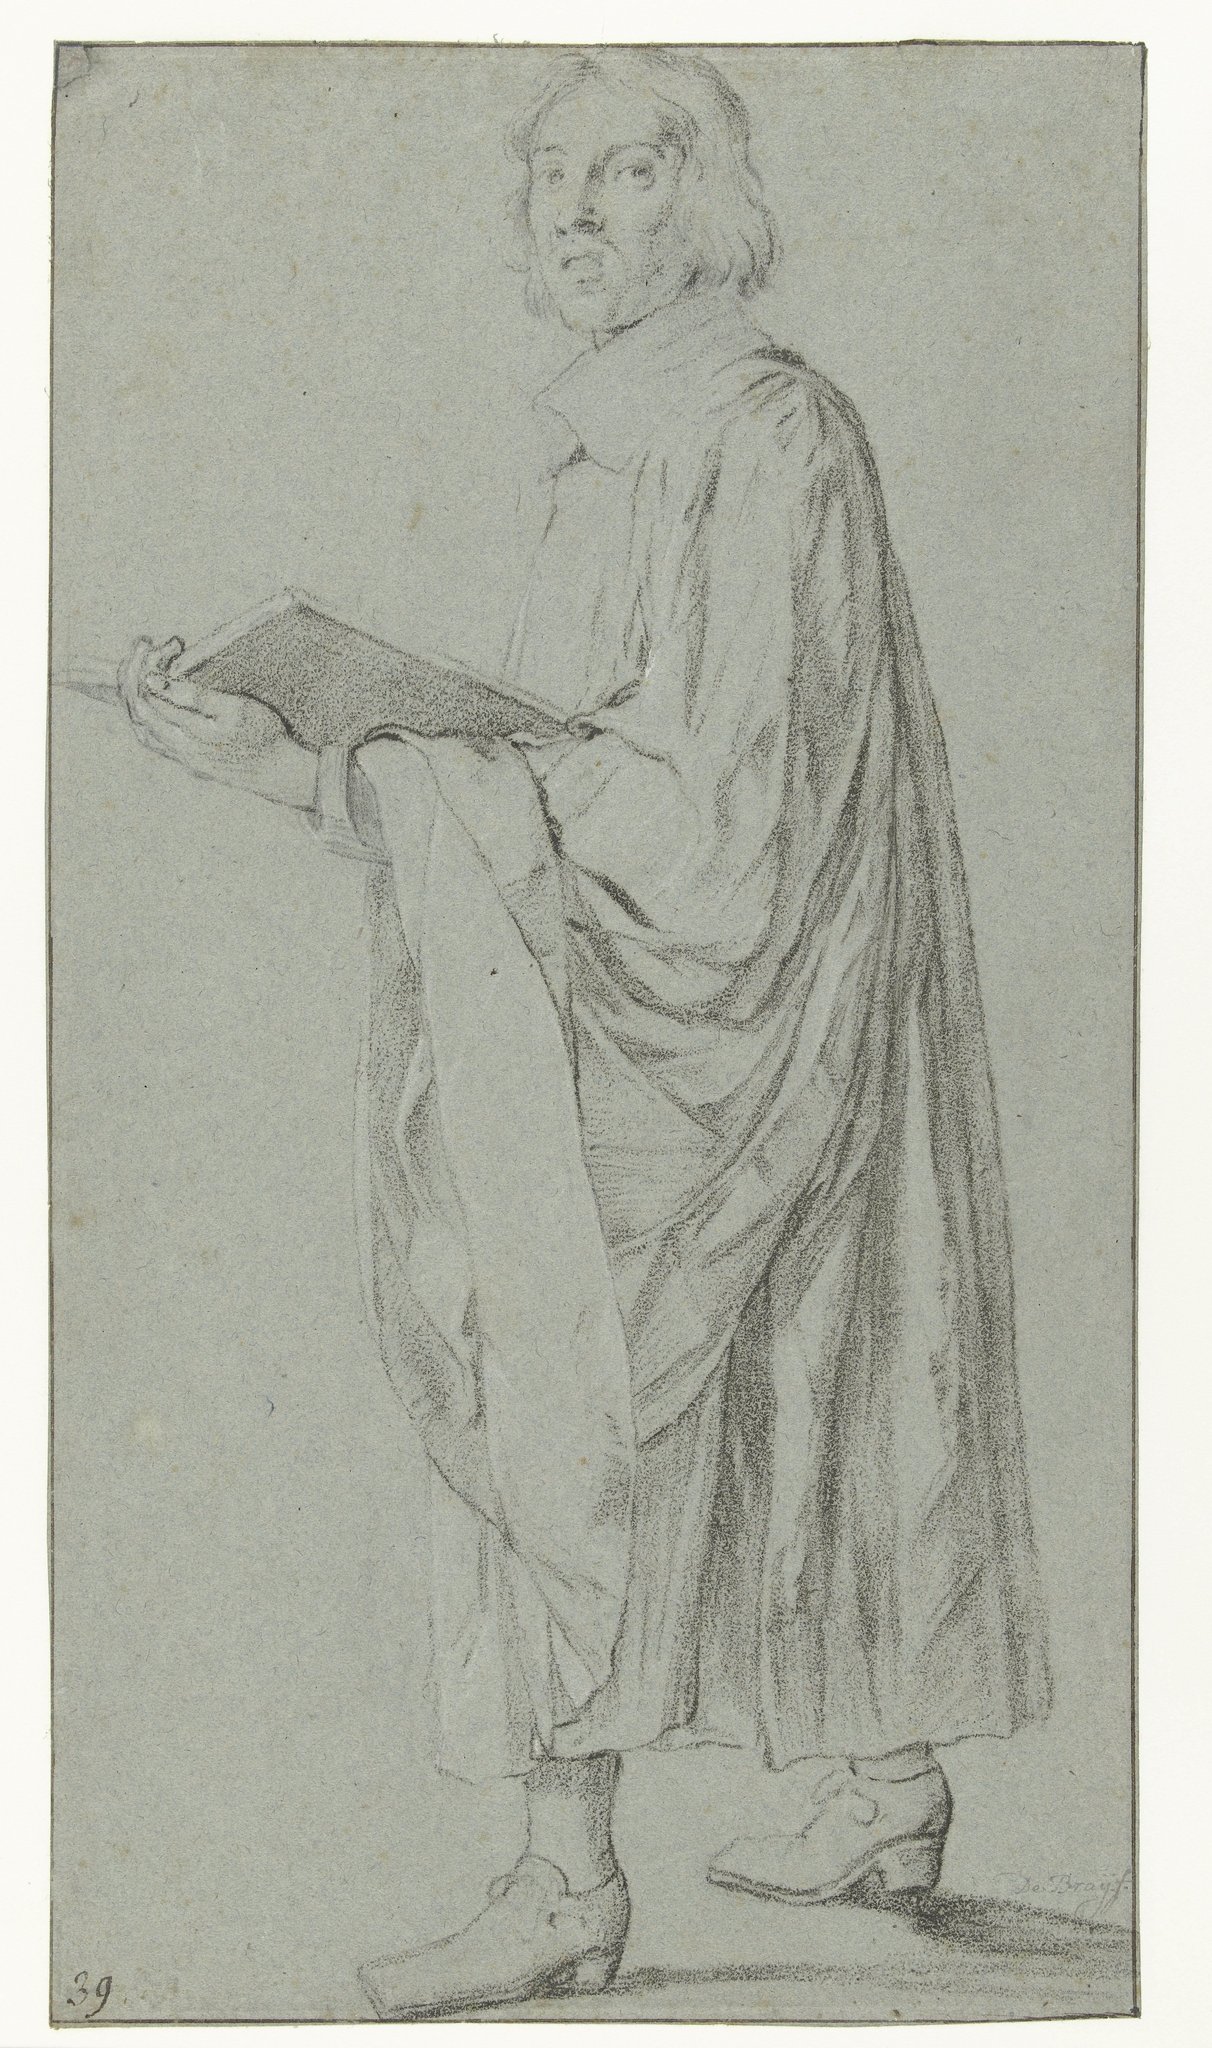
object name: drawing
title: Study of a Standing Cleric, Holding a Book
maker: jan de bray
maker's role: draughtsman, print maker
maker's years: 1627-1697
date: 1637-1697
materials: chalk, paper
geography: haarlem